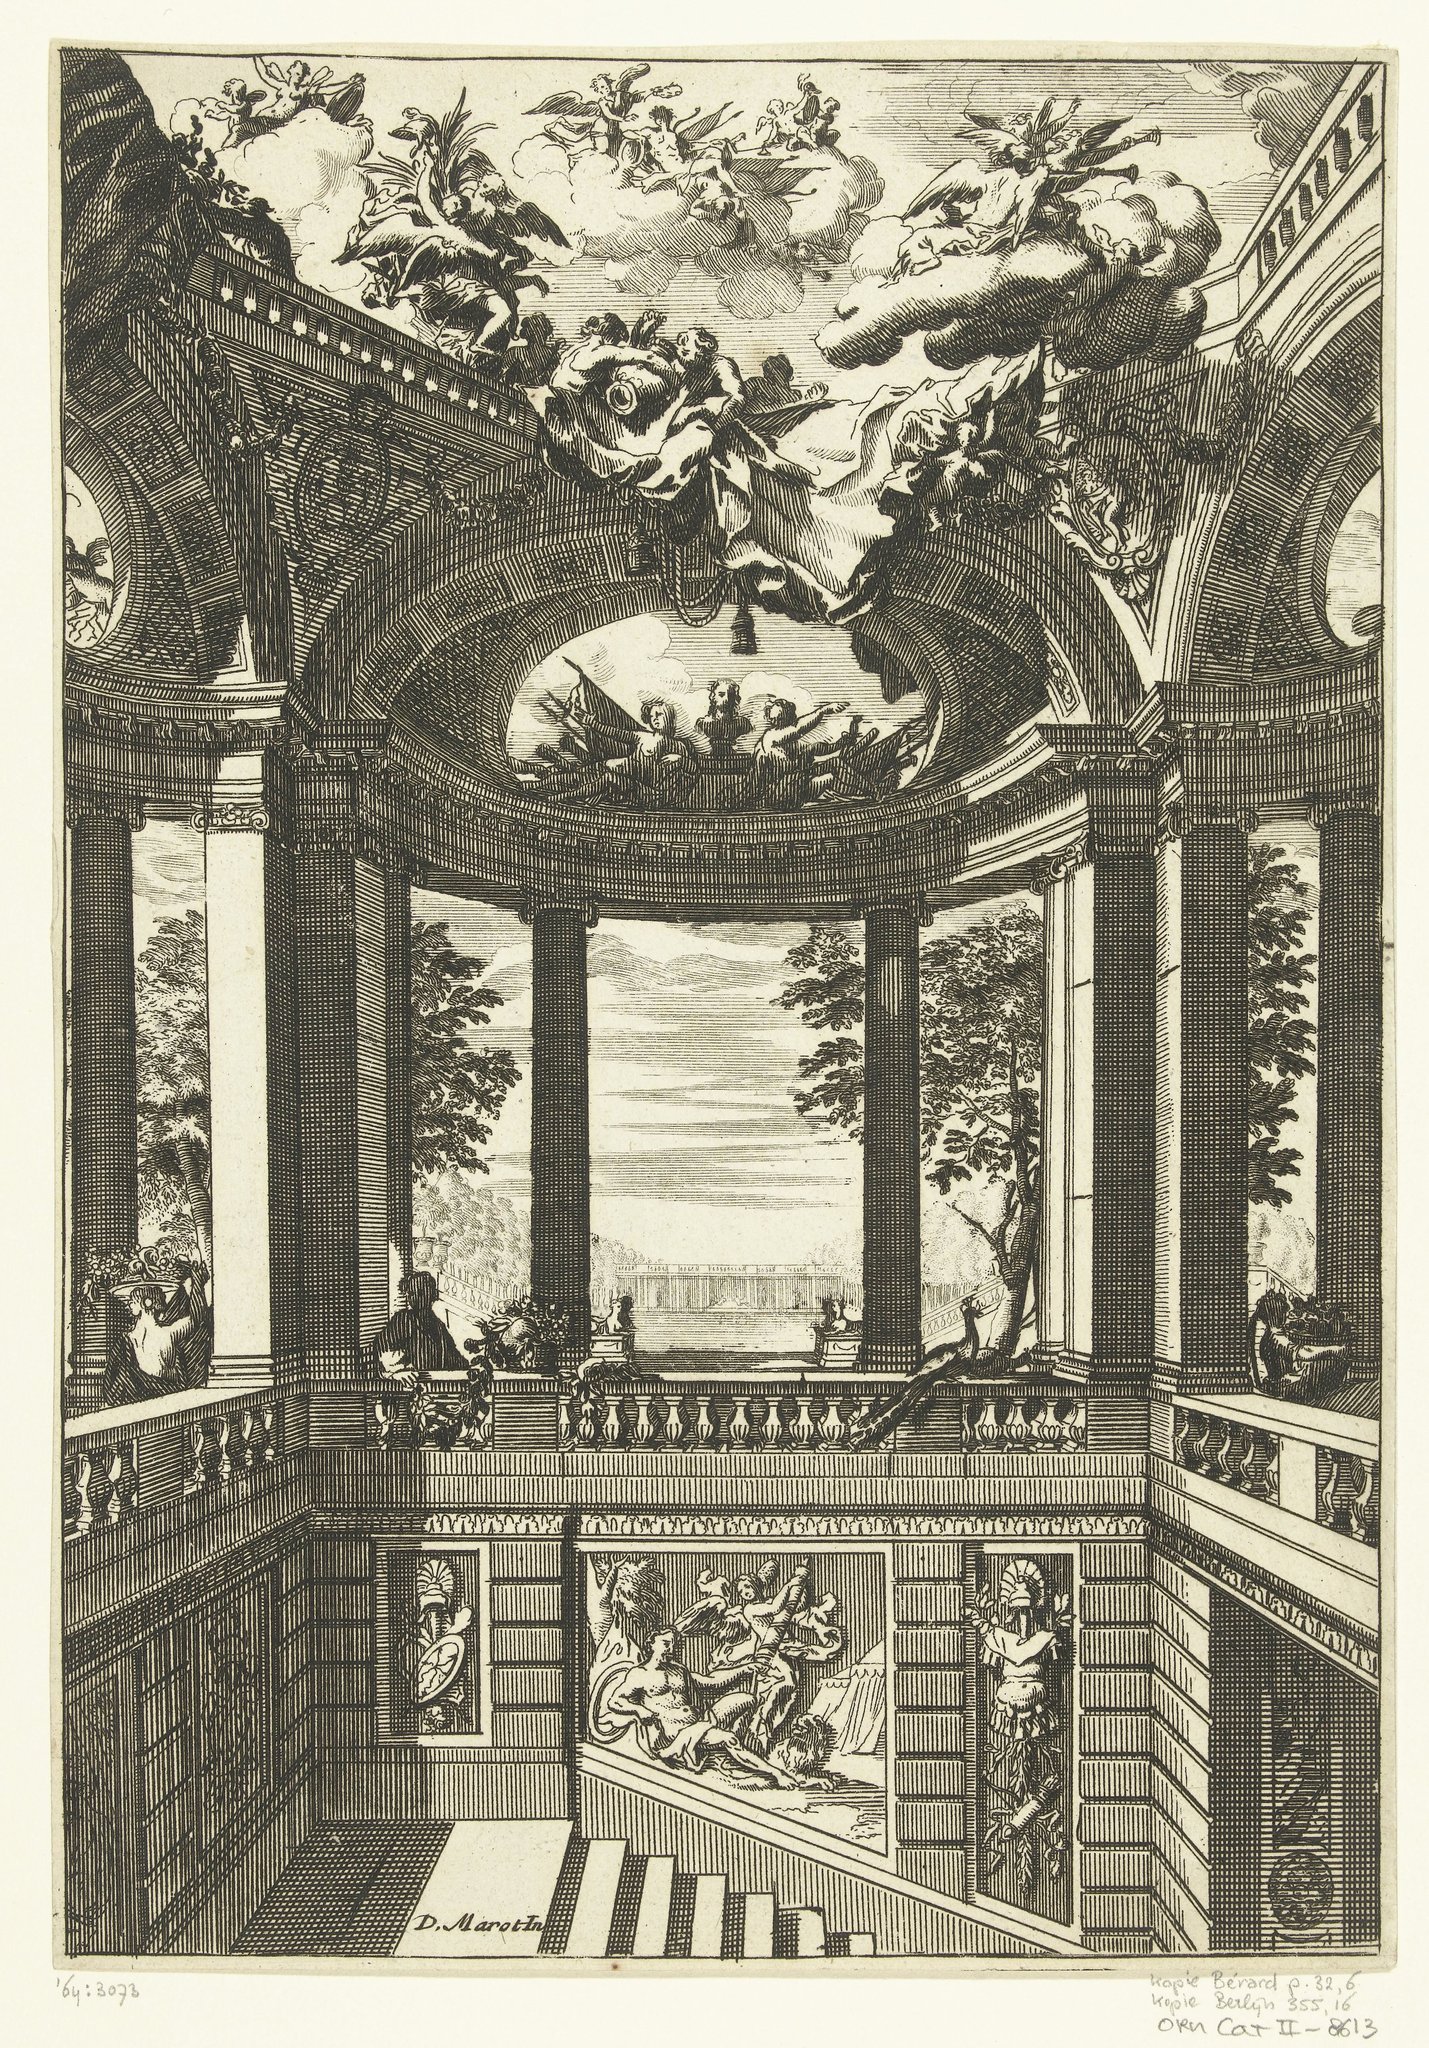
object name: ornament print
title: Geschilderde muurdecoraties voor kamers en trappenhuizen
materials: paper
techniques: etching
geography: netherlands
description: De muren zijn onderling verbonden door Ionische pilasters en zuilen. Deze geven steun aan een architraaf waarop een achthoekige balustrade rust. Tegenzijdige kopie naar prent uit serie Nouveaux Liure de Pintures de Salles et d'Escalliers. Eén van 6 bladen.